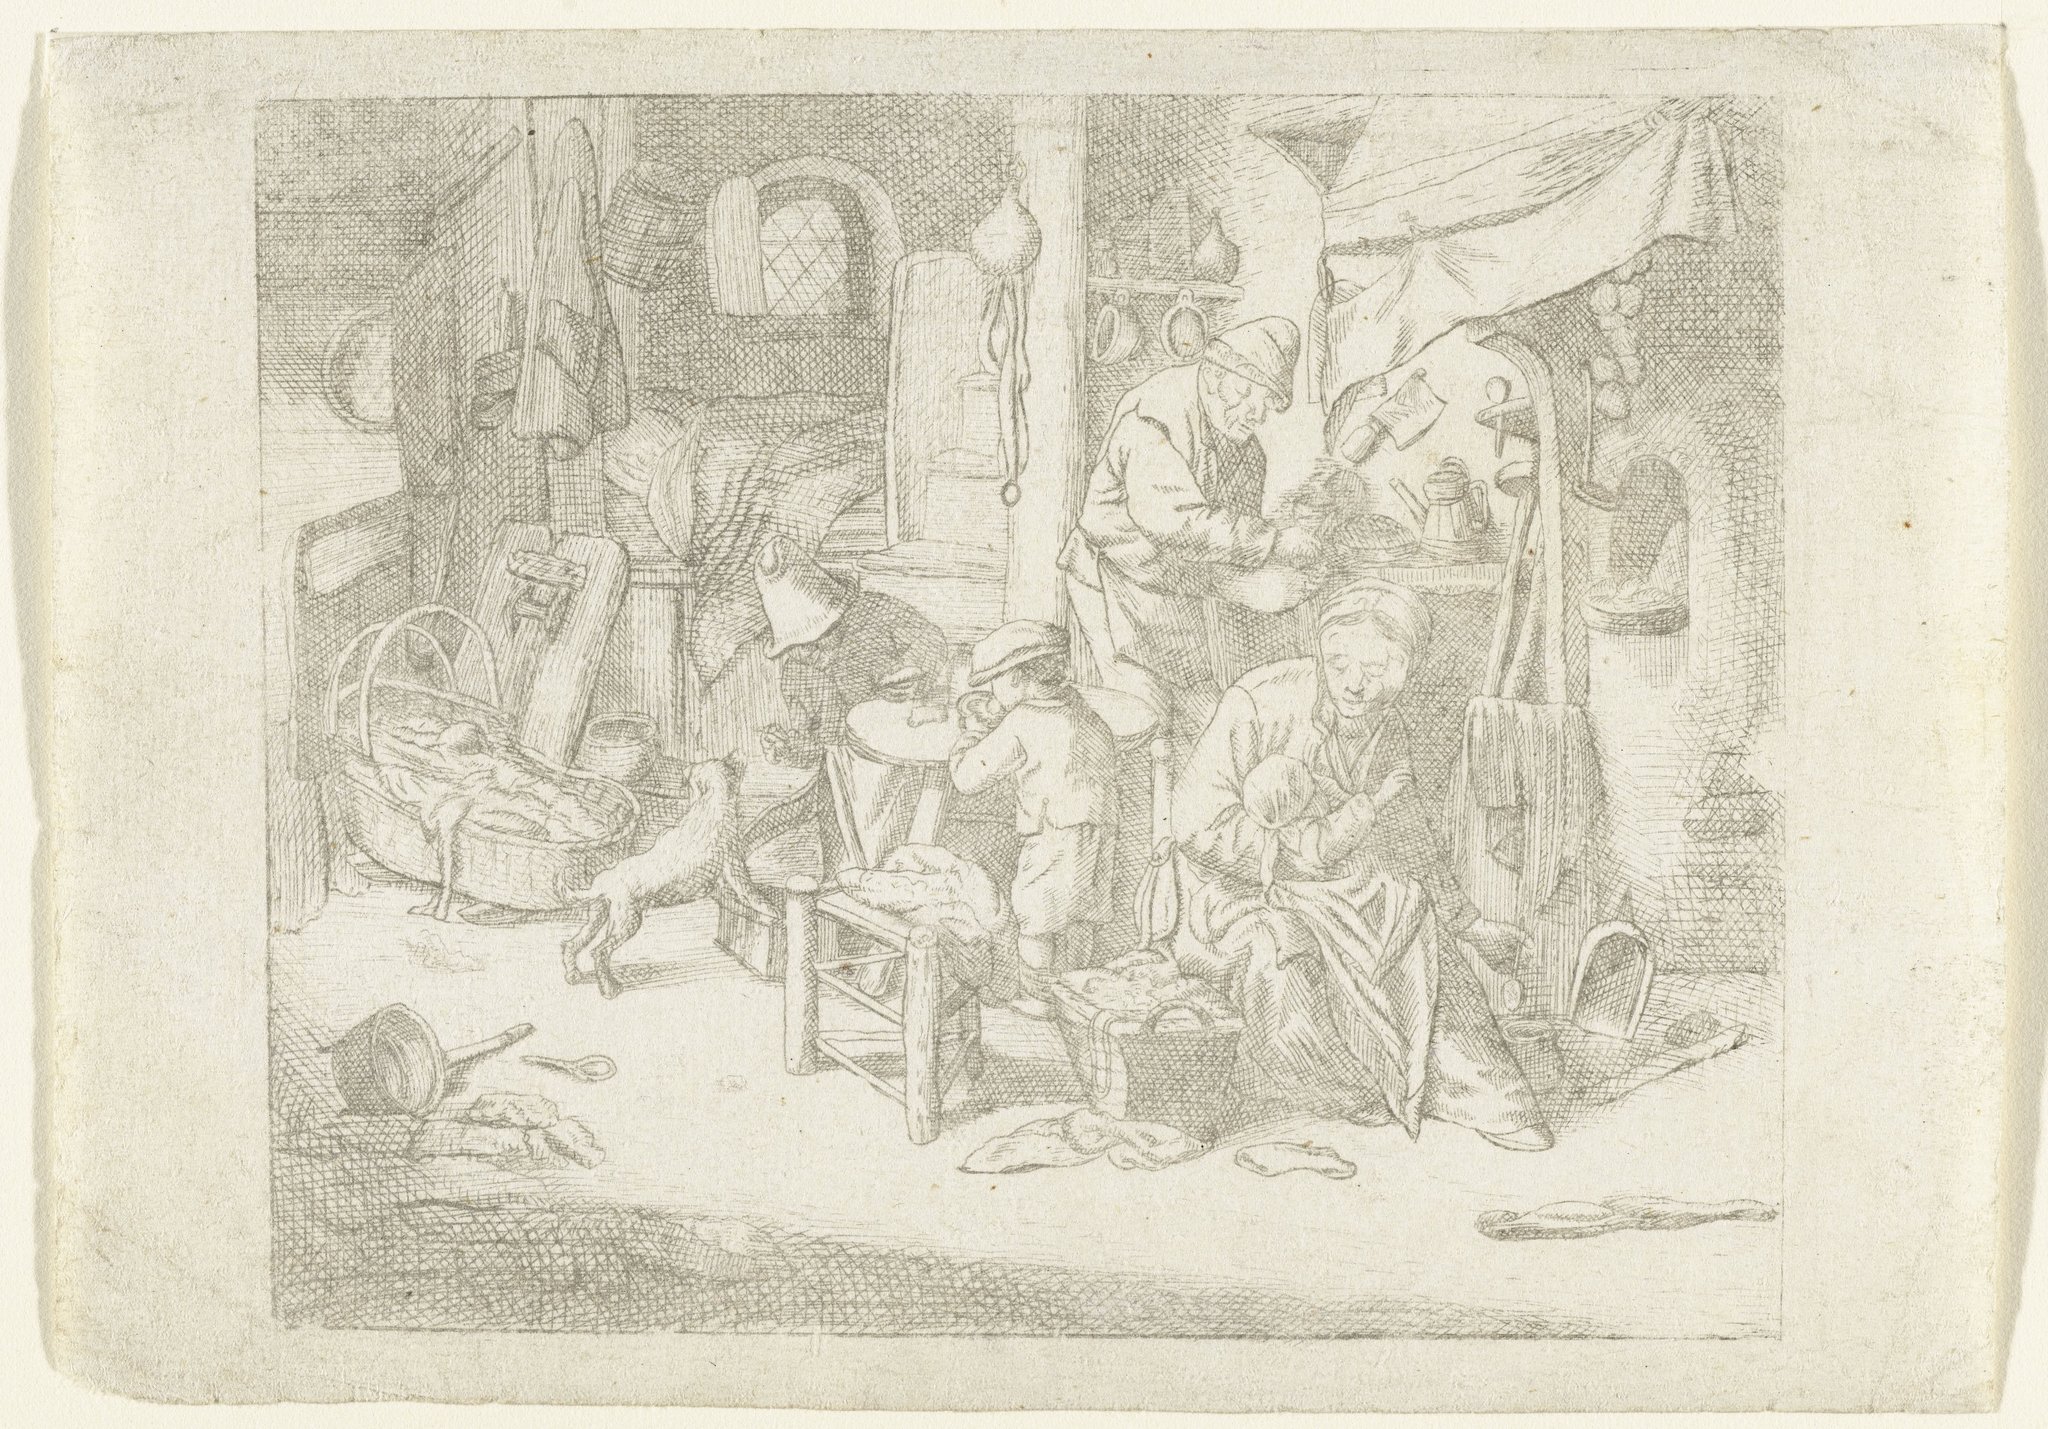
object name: print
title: Het boerenhuishouden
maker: Anonymous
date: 1647-1745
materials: paper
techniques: etching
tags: family life, interior of the house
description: Kopie naar prent van Adriaen van Ostade waarbij slechts de onderste helft van de originele compositie is overgenomen.